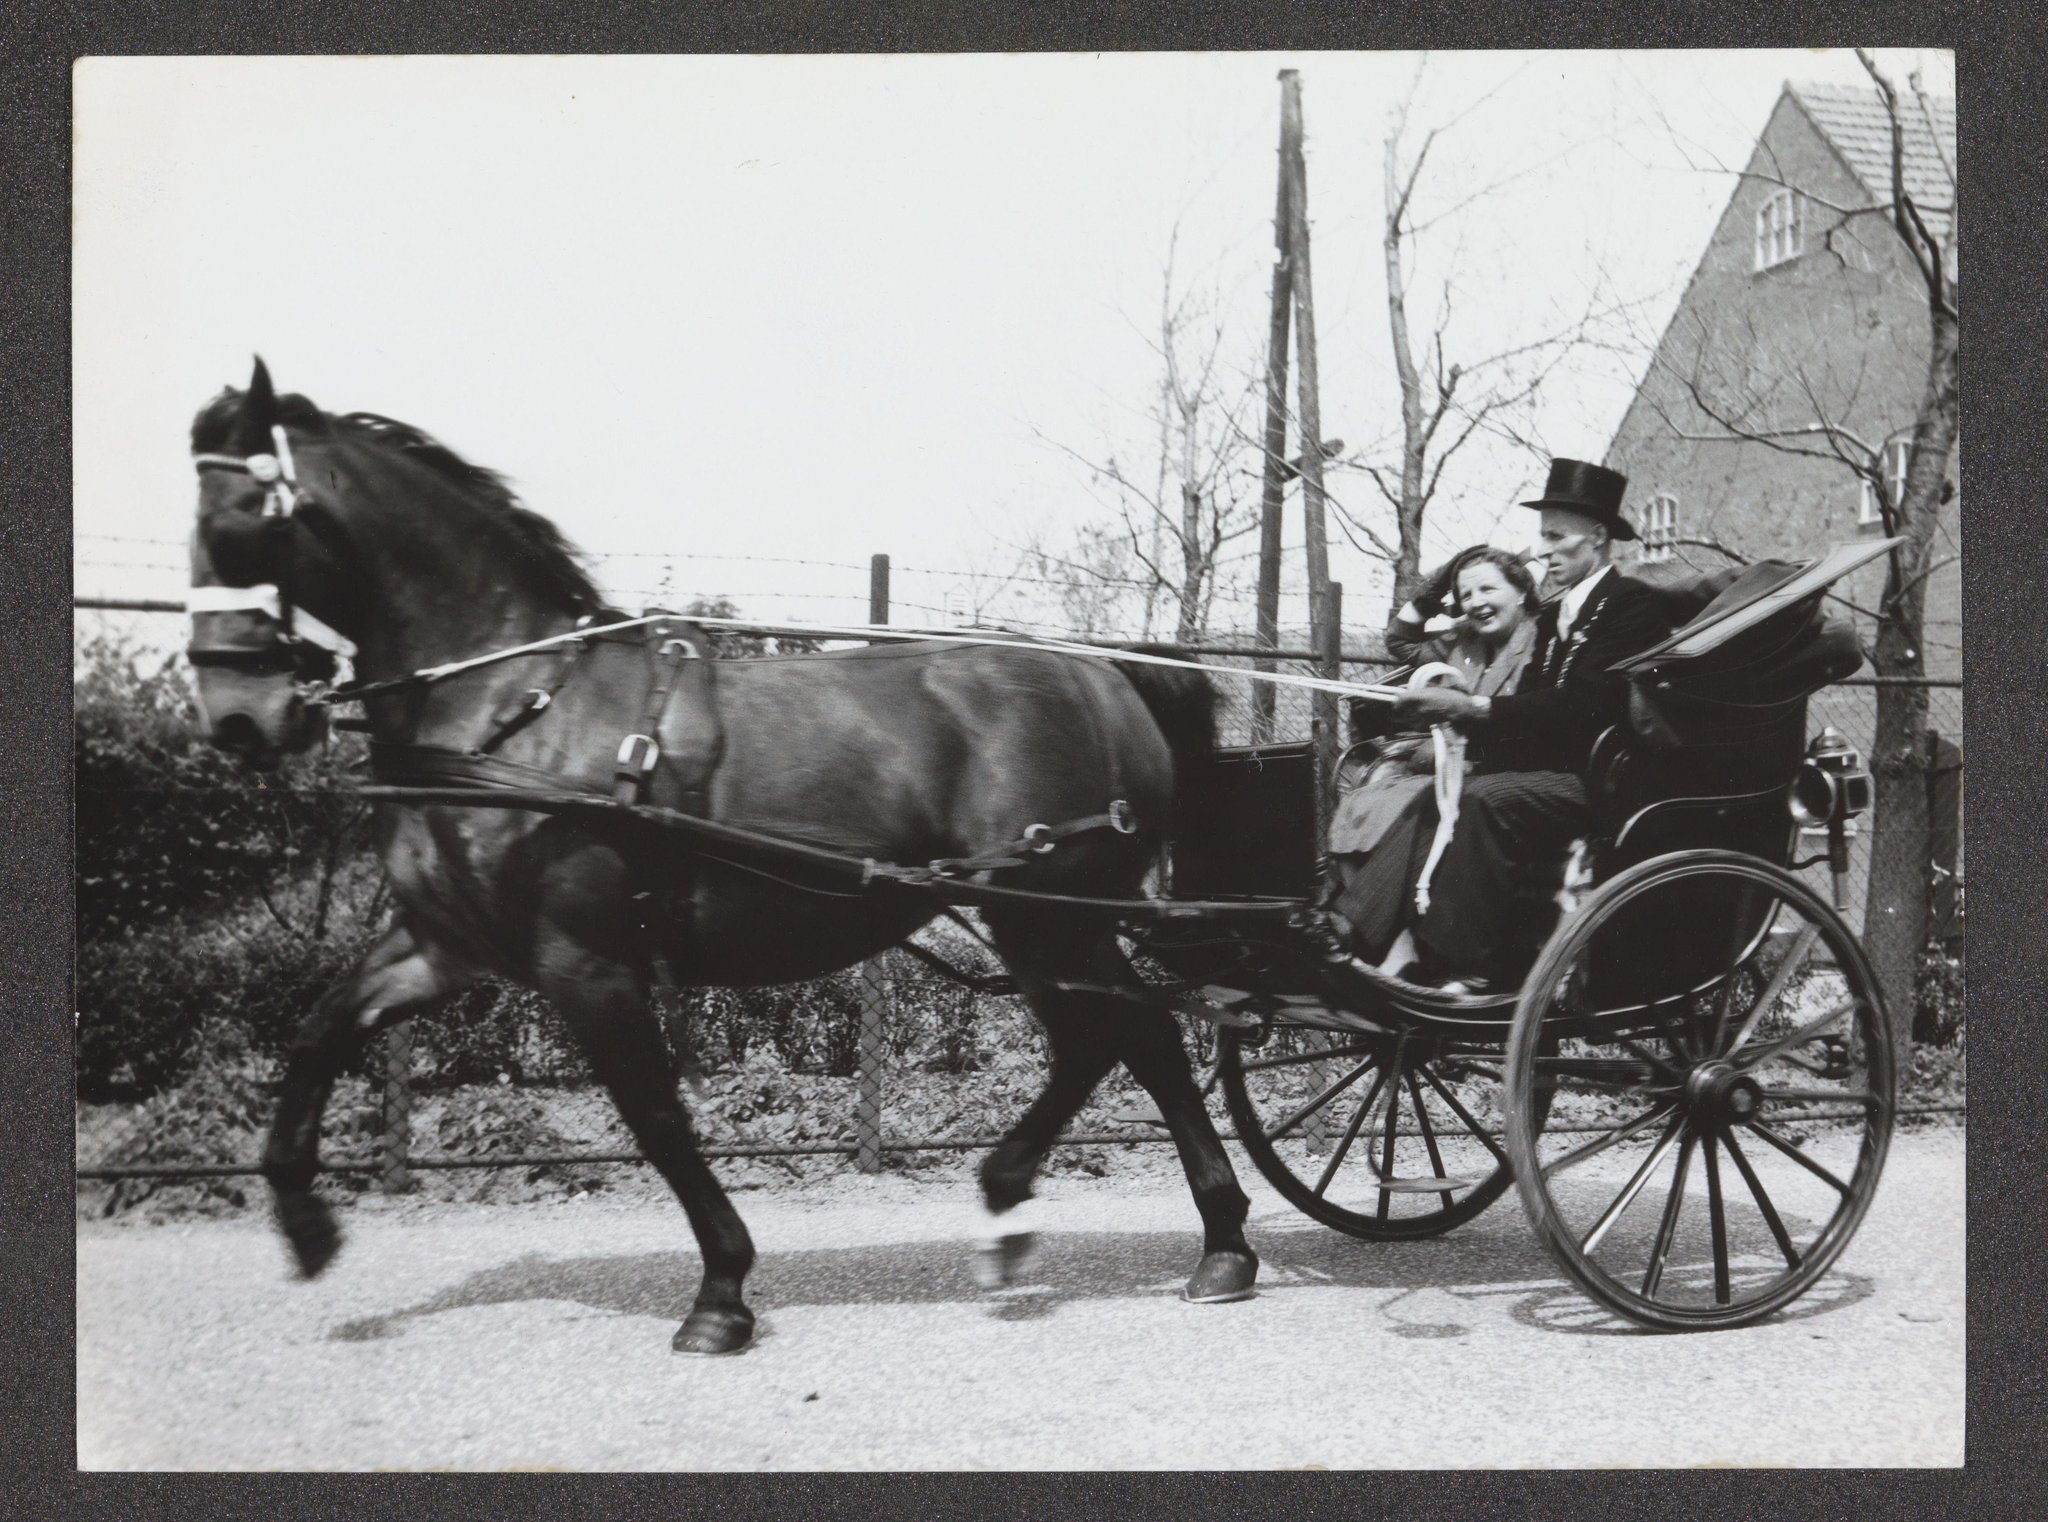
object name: photograph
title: Koningin Juliana in een rijtuig gereden door de burgemeester van Nieuw Helvoet, L. Riedijk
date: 1957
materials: cardboard, paper, photographic support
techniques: gelatin silver print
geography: netherlands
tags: juliana of the netherlands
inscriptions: annotation: ‘Tuesday may 14th H.M. the Queen paid a visit to Voorne ... which was droven by the bourgemaster of Nieuw Helvoet’